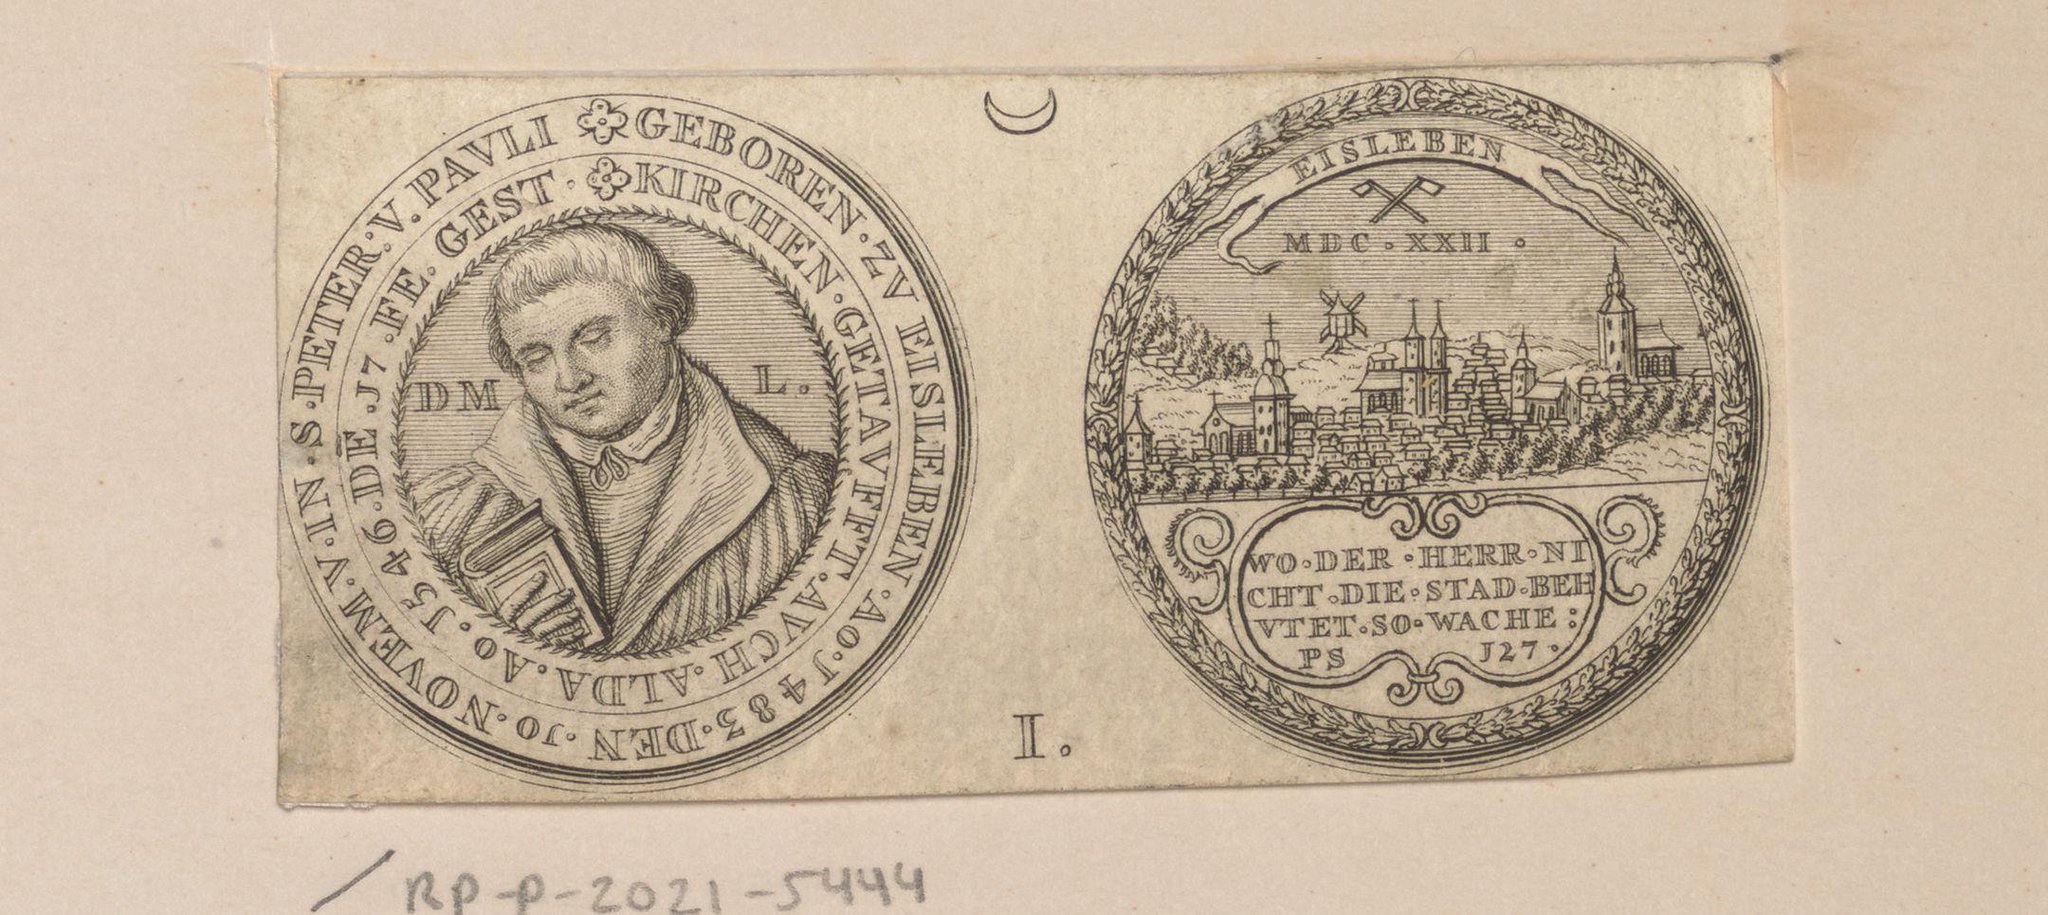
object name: print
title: Voor- en achterzijde van een penning met het portret van Martin Luther en gezicht op Eisleben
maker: Anonymous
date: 1735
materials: paper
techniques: engraving, etching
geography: northern netherlands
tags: martin luther, city-view, and landscape with man-made constructions, historical persons, medal (considered as a piece of sculpture, regardless of its specific function)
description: Prent met tekst in boekdruk op verso gebruikt in: Mieris, Frans van. Histori der Nederlandsche vorsten (...). Den Haag: Pieter de Hondt, 1735, dl. 3, p. 136. Met bovenin de prent het symbool voor zilver.